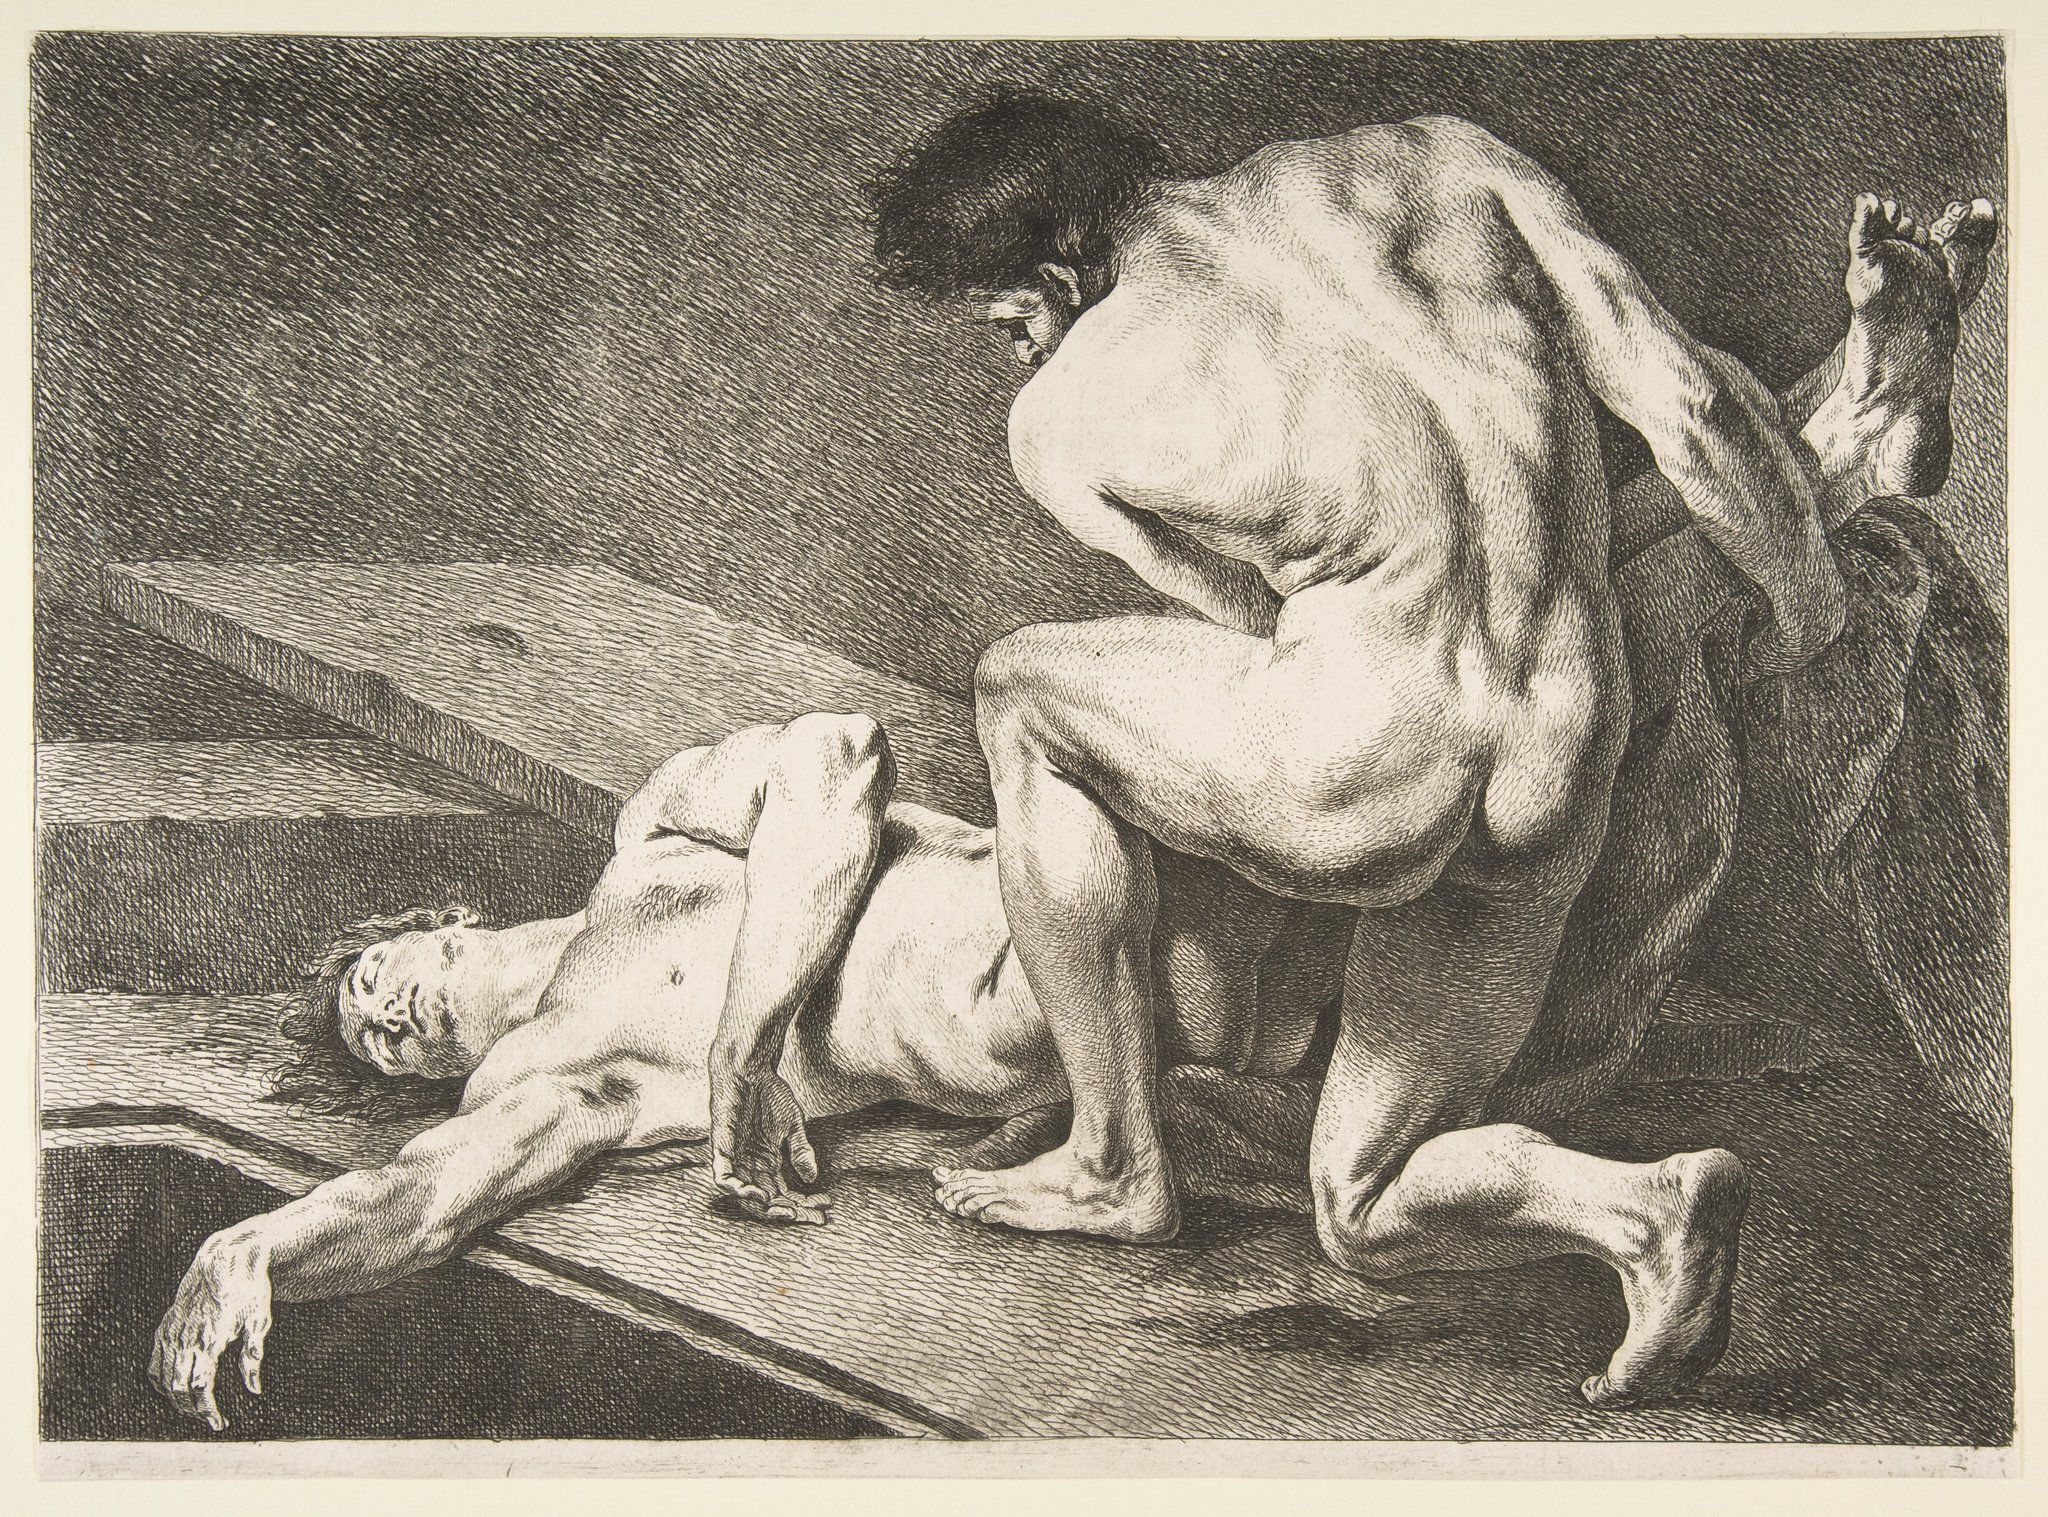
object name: print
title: An "Académie": One Man Lifting the Legs of Another Man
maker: carle (charles andré) vanloo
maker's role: artist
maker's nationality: french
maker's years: 1705-1765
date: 1742-1743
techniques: etching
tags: male nudes